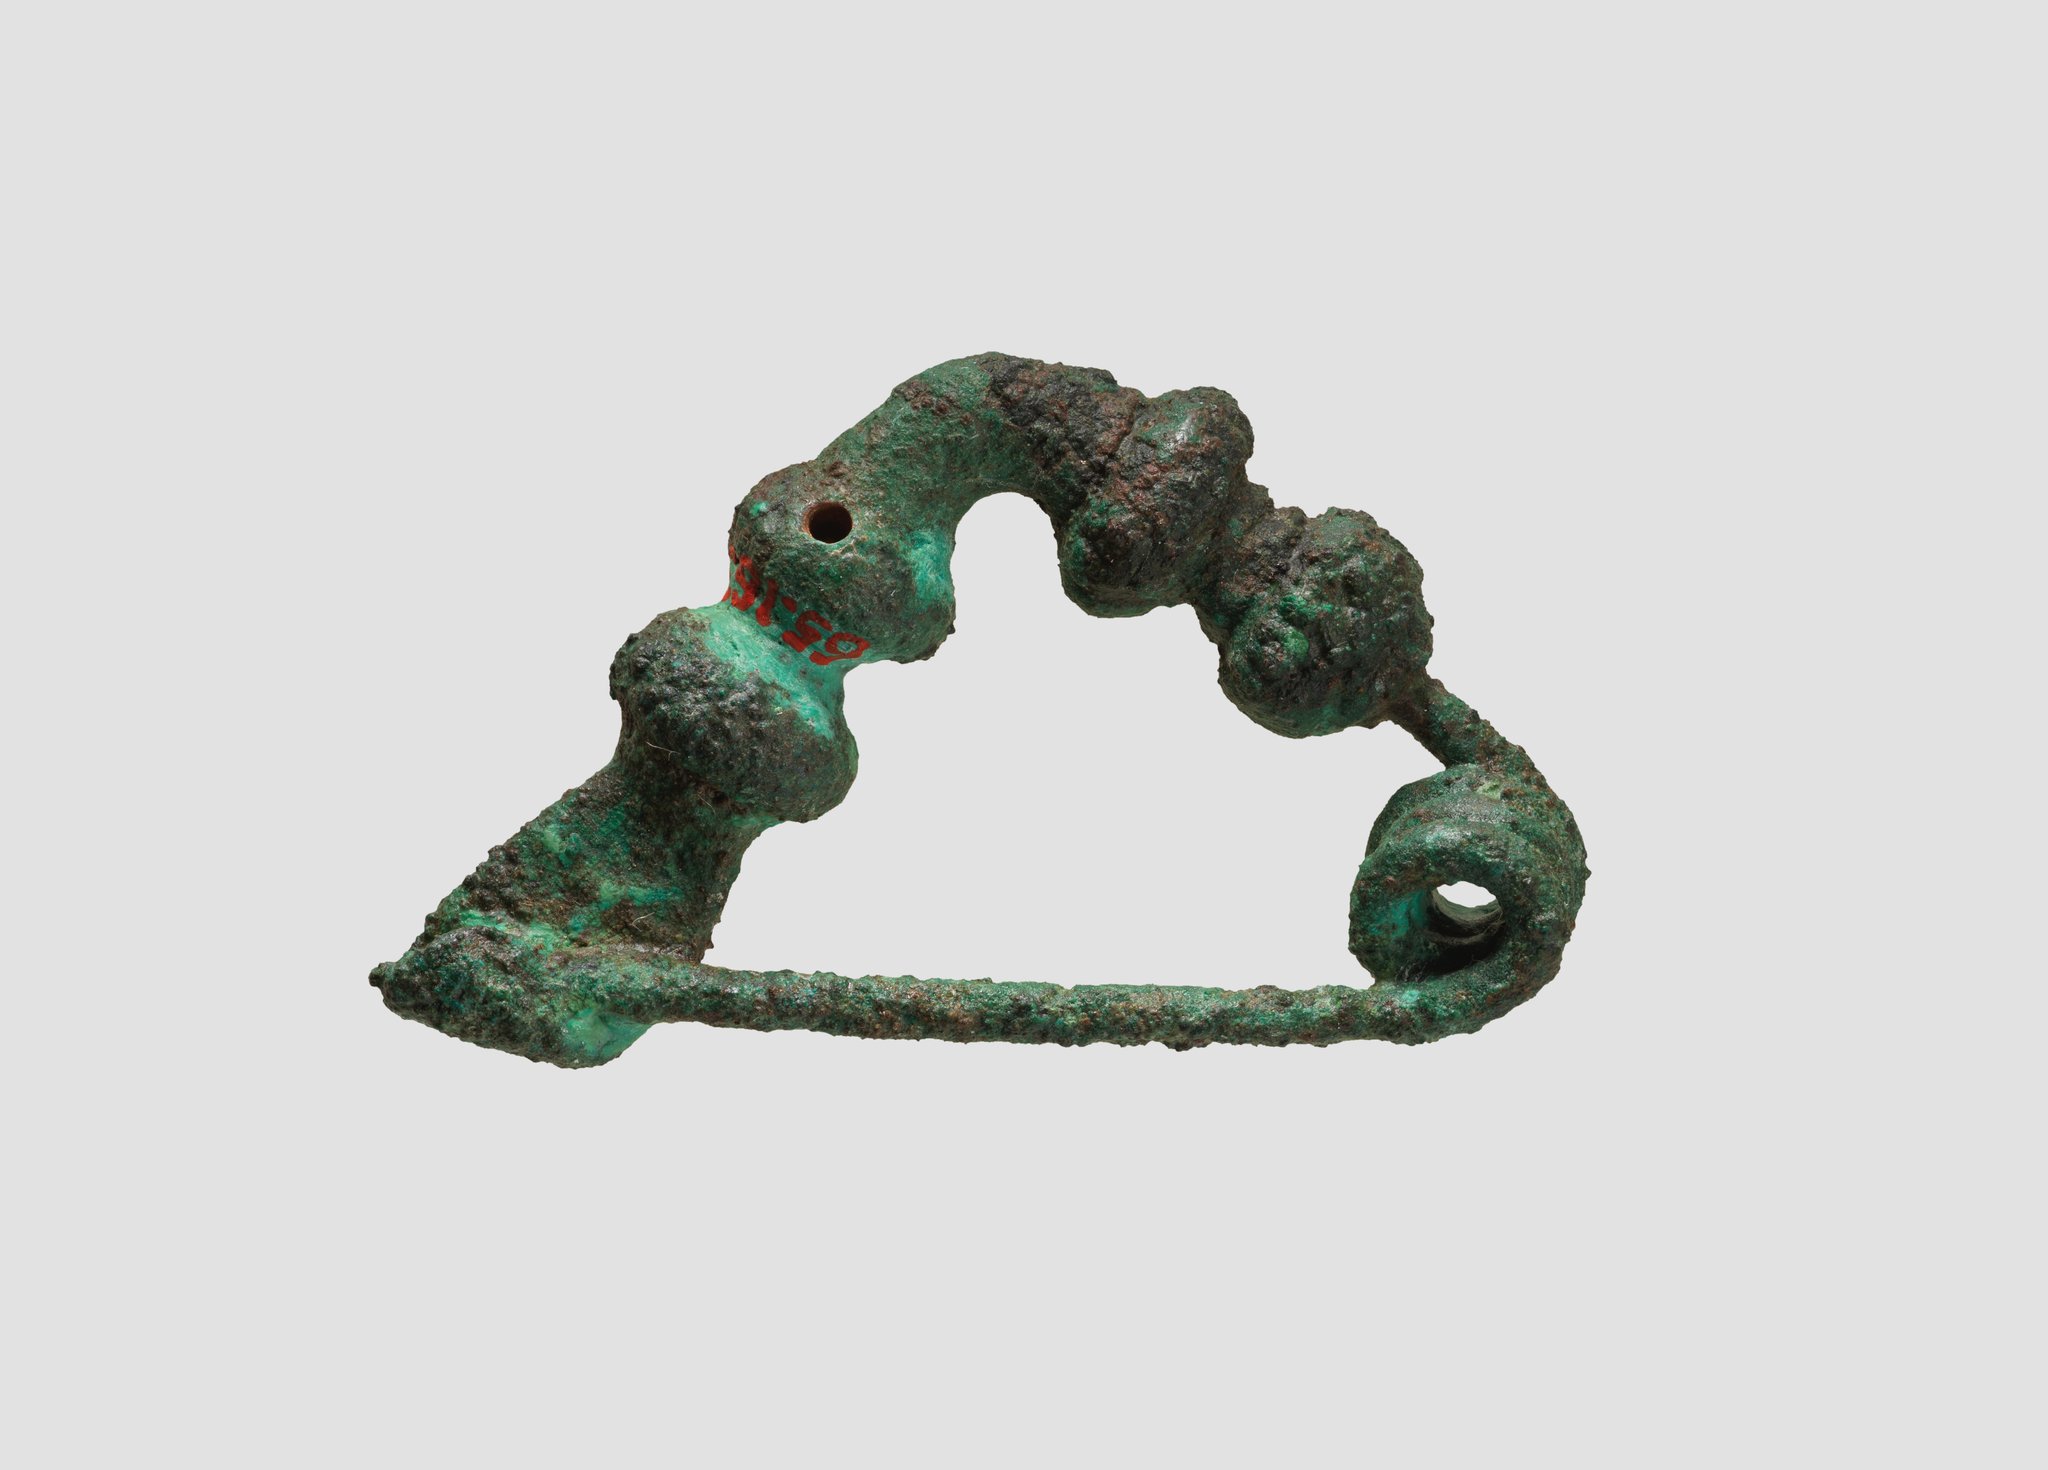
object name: fibula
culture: iranian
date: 700-401 BCE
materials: bronze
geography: iran